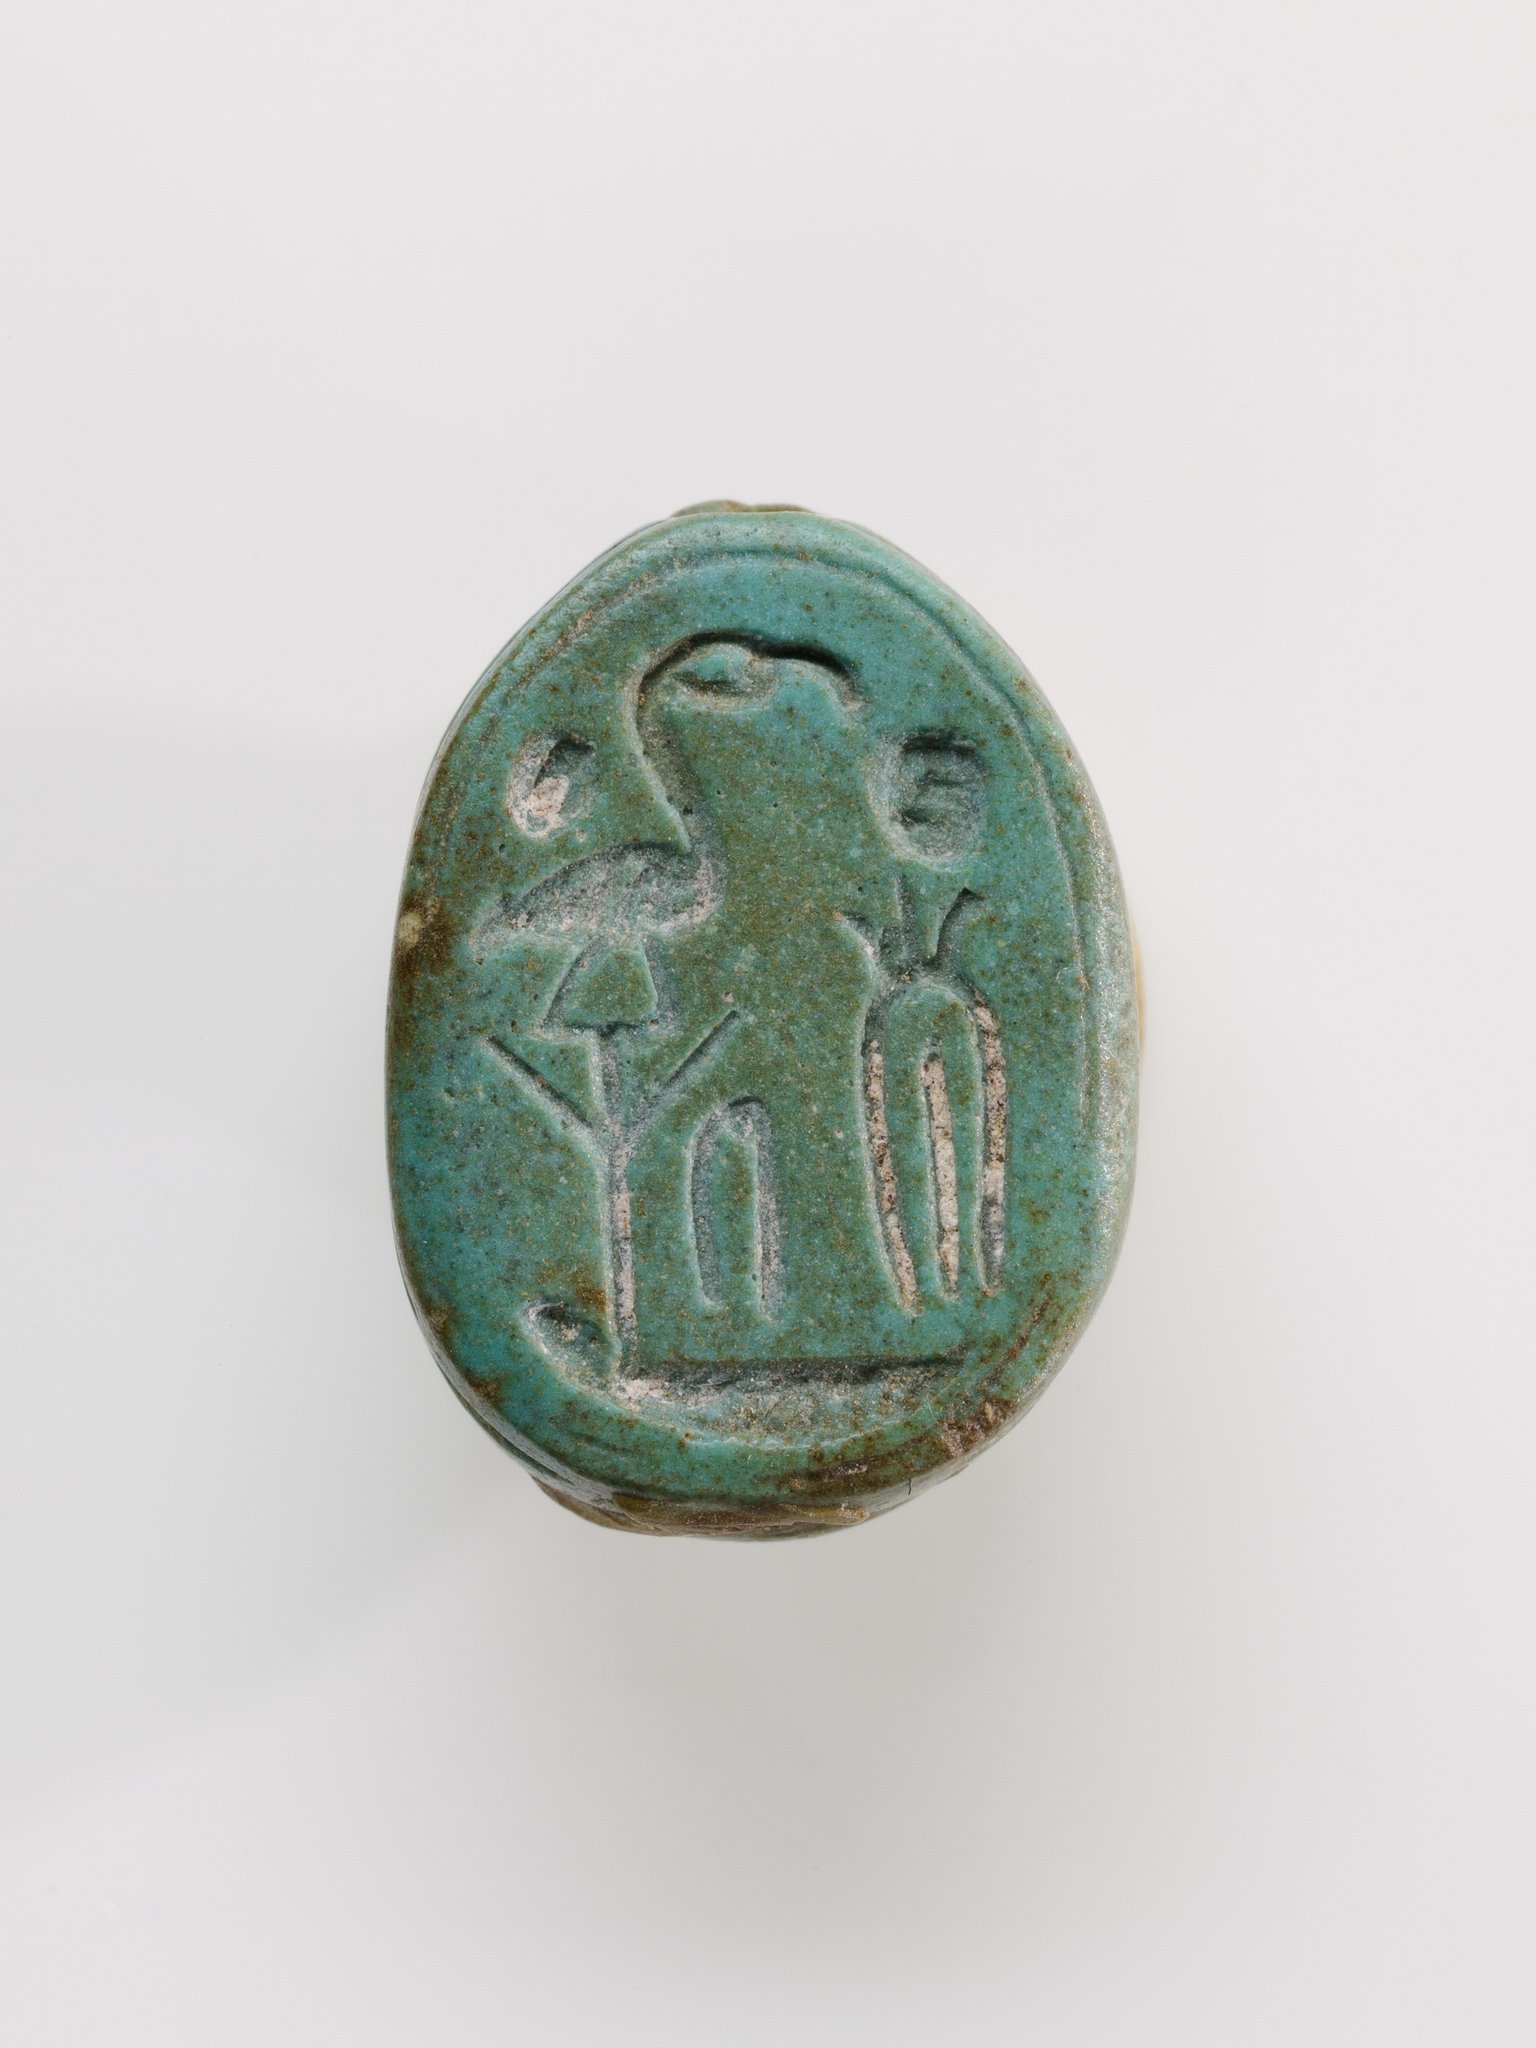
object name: scarab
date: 1492-1479 BCE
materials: paste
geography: egypt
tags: hieroglyphs,scarabs